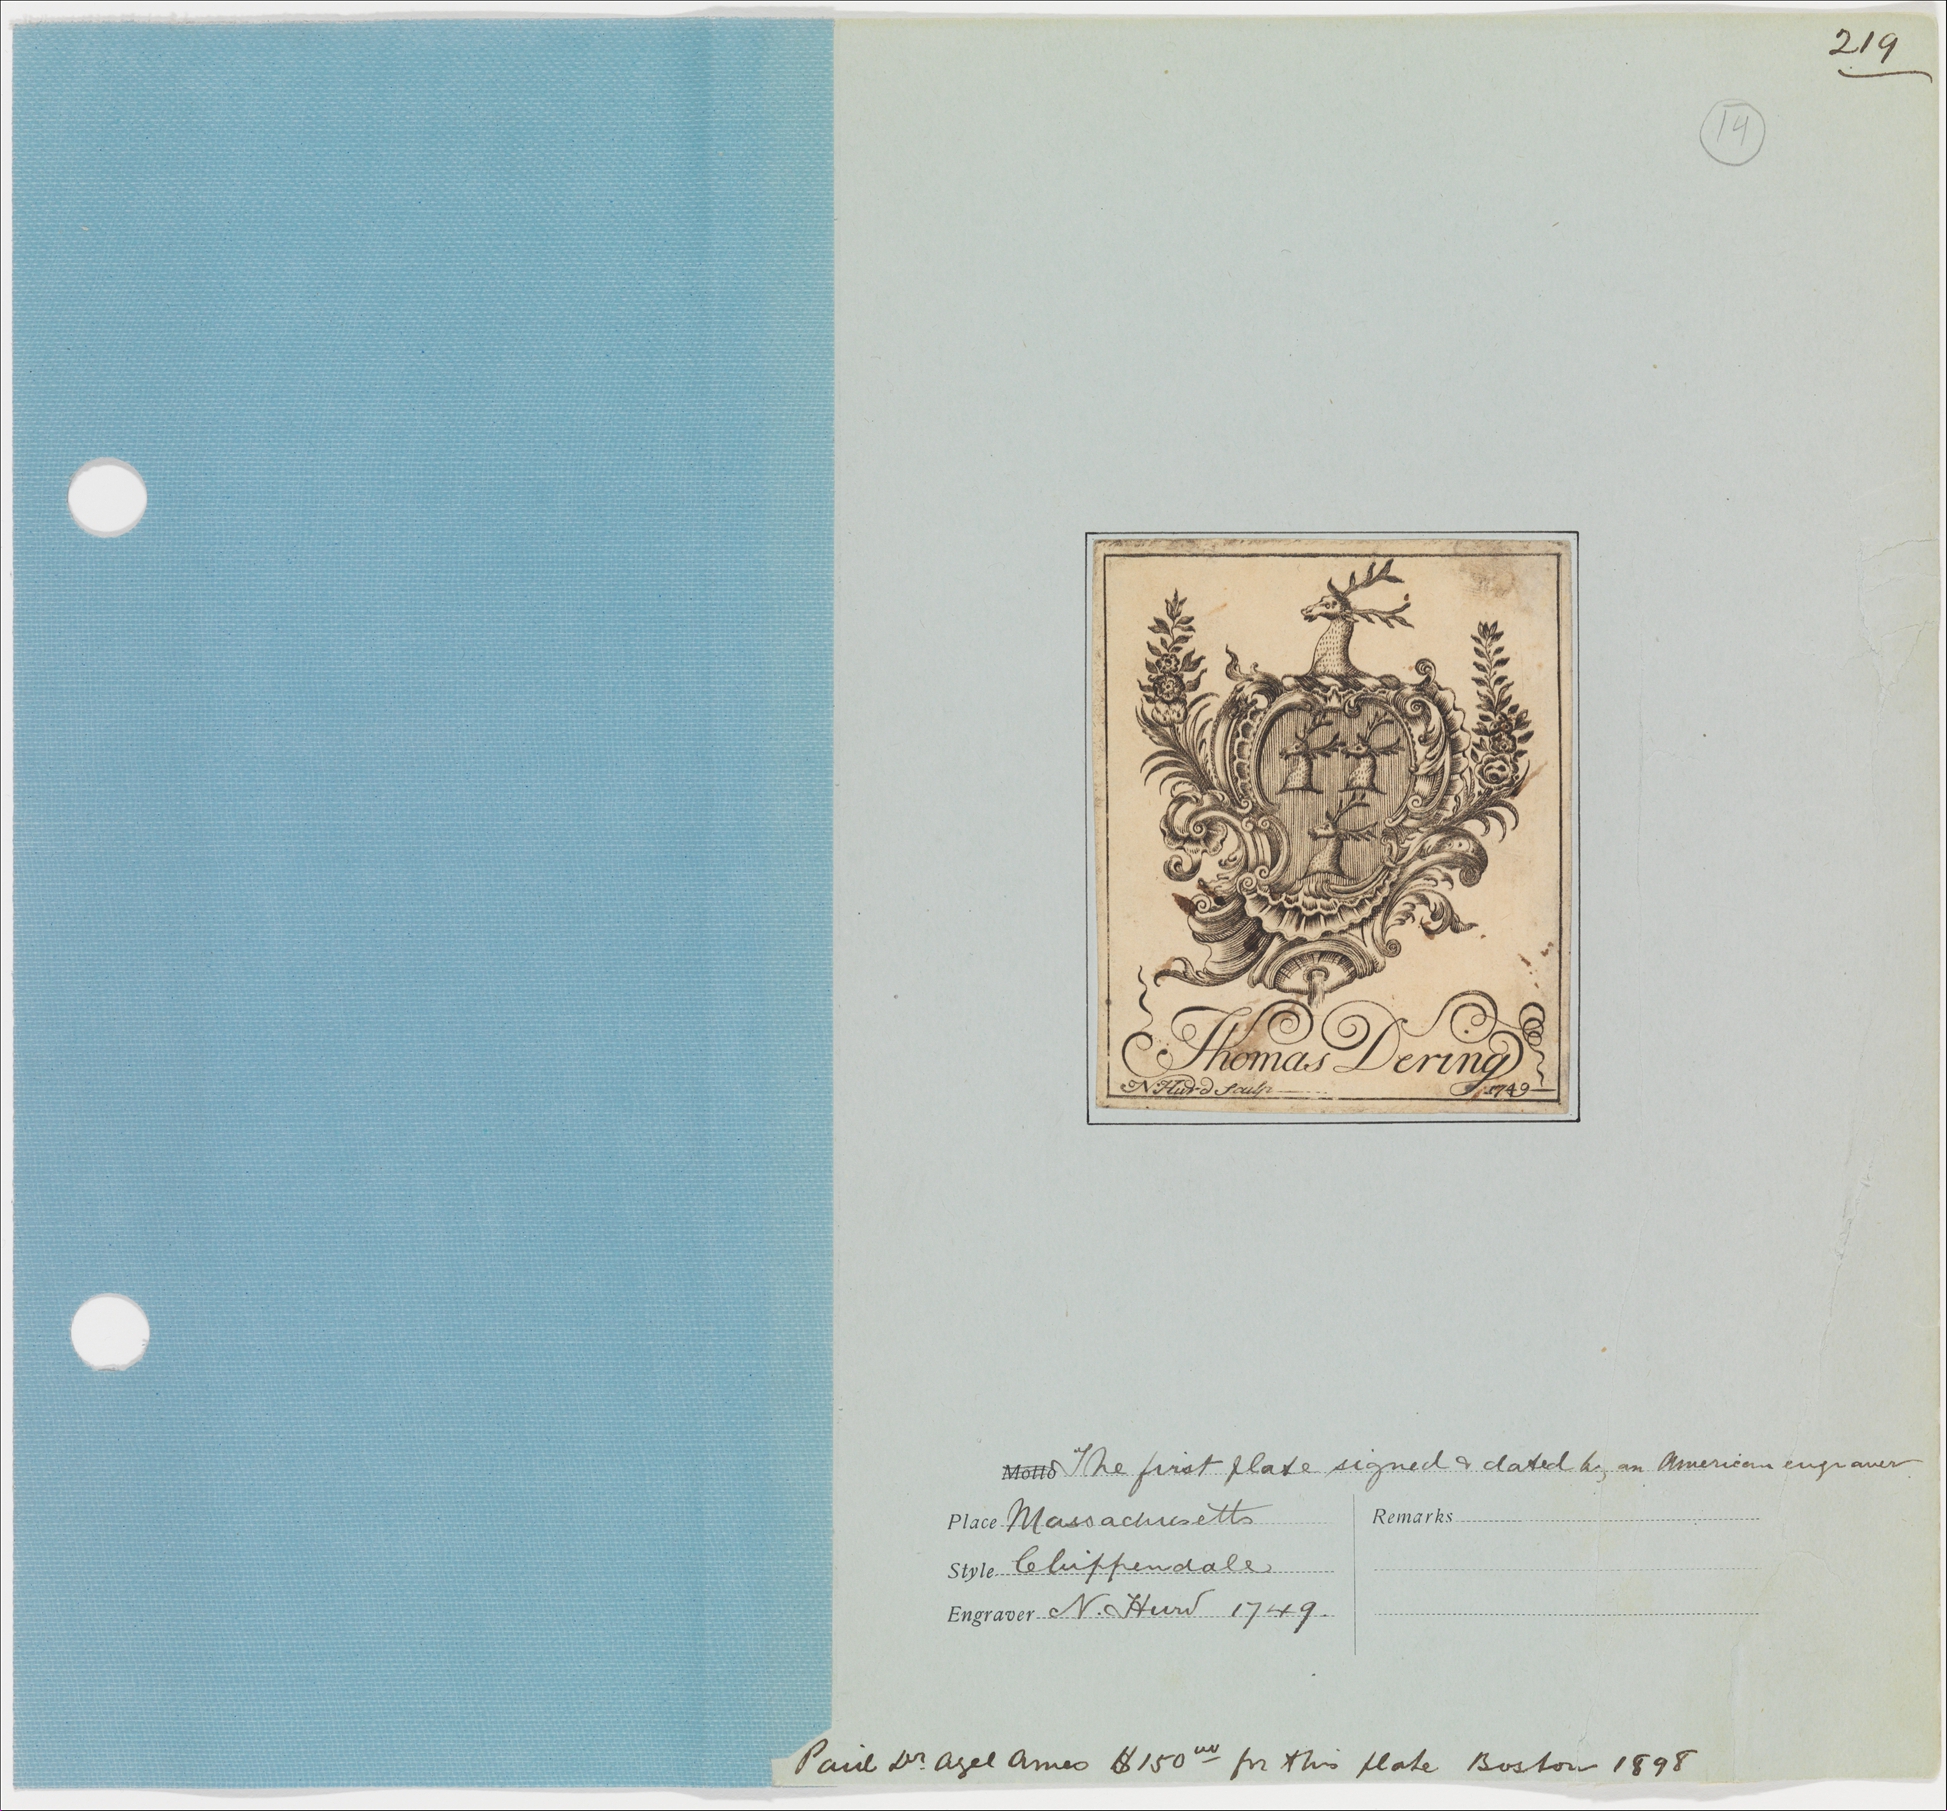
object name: print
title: Bookplate of Thomas Dering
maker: nathaniel hurd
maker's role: artist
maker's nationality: american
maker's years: 1729-1777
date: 1749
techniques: engraving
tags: deer,coat of arms